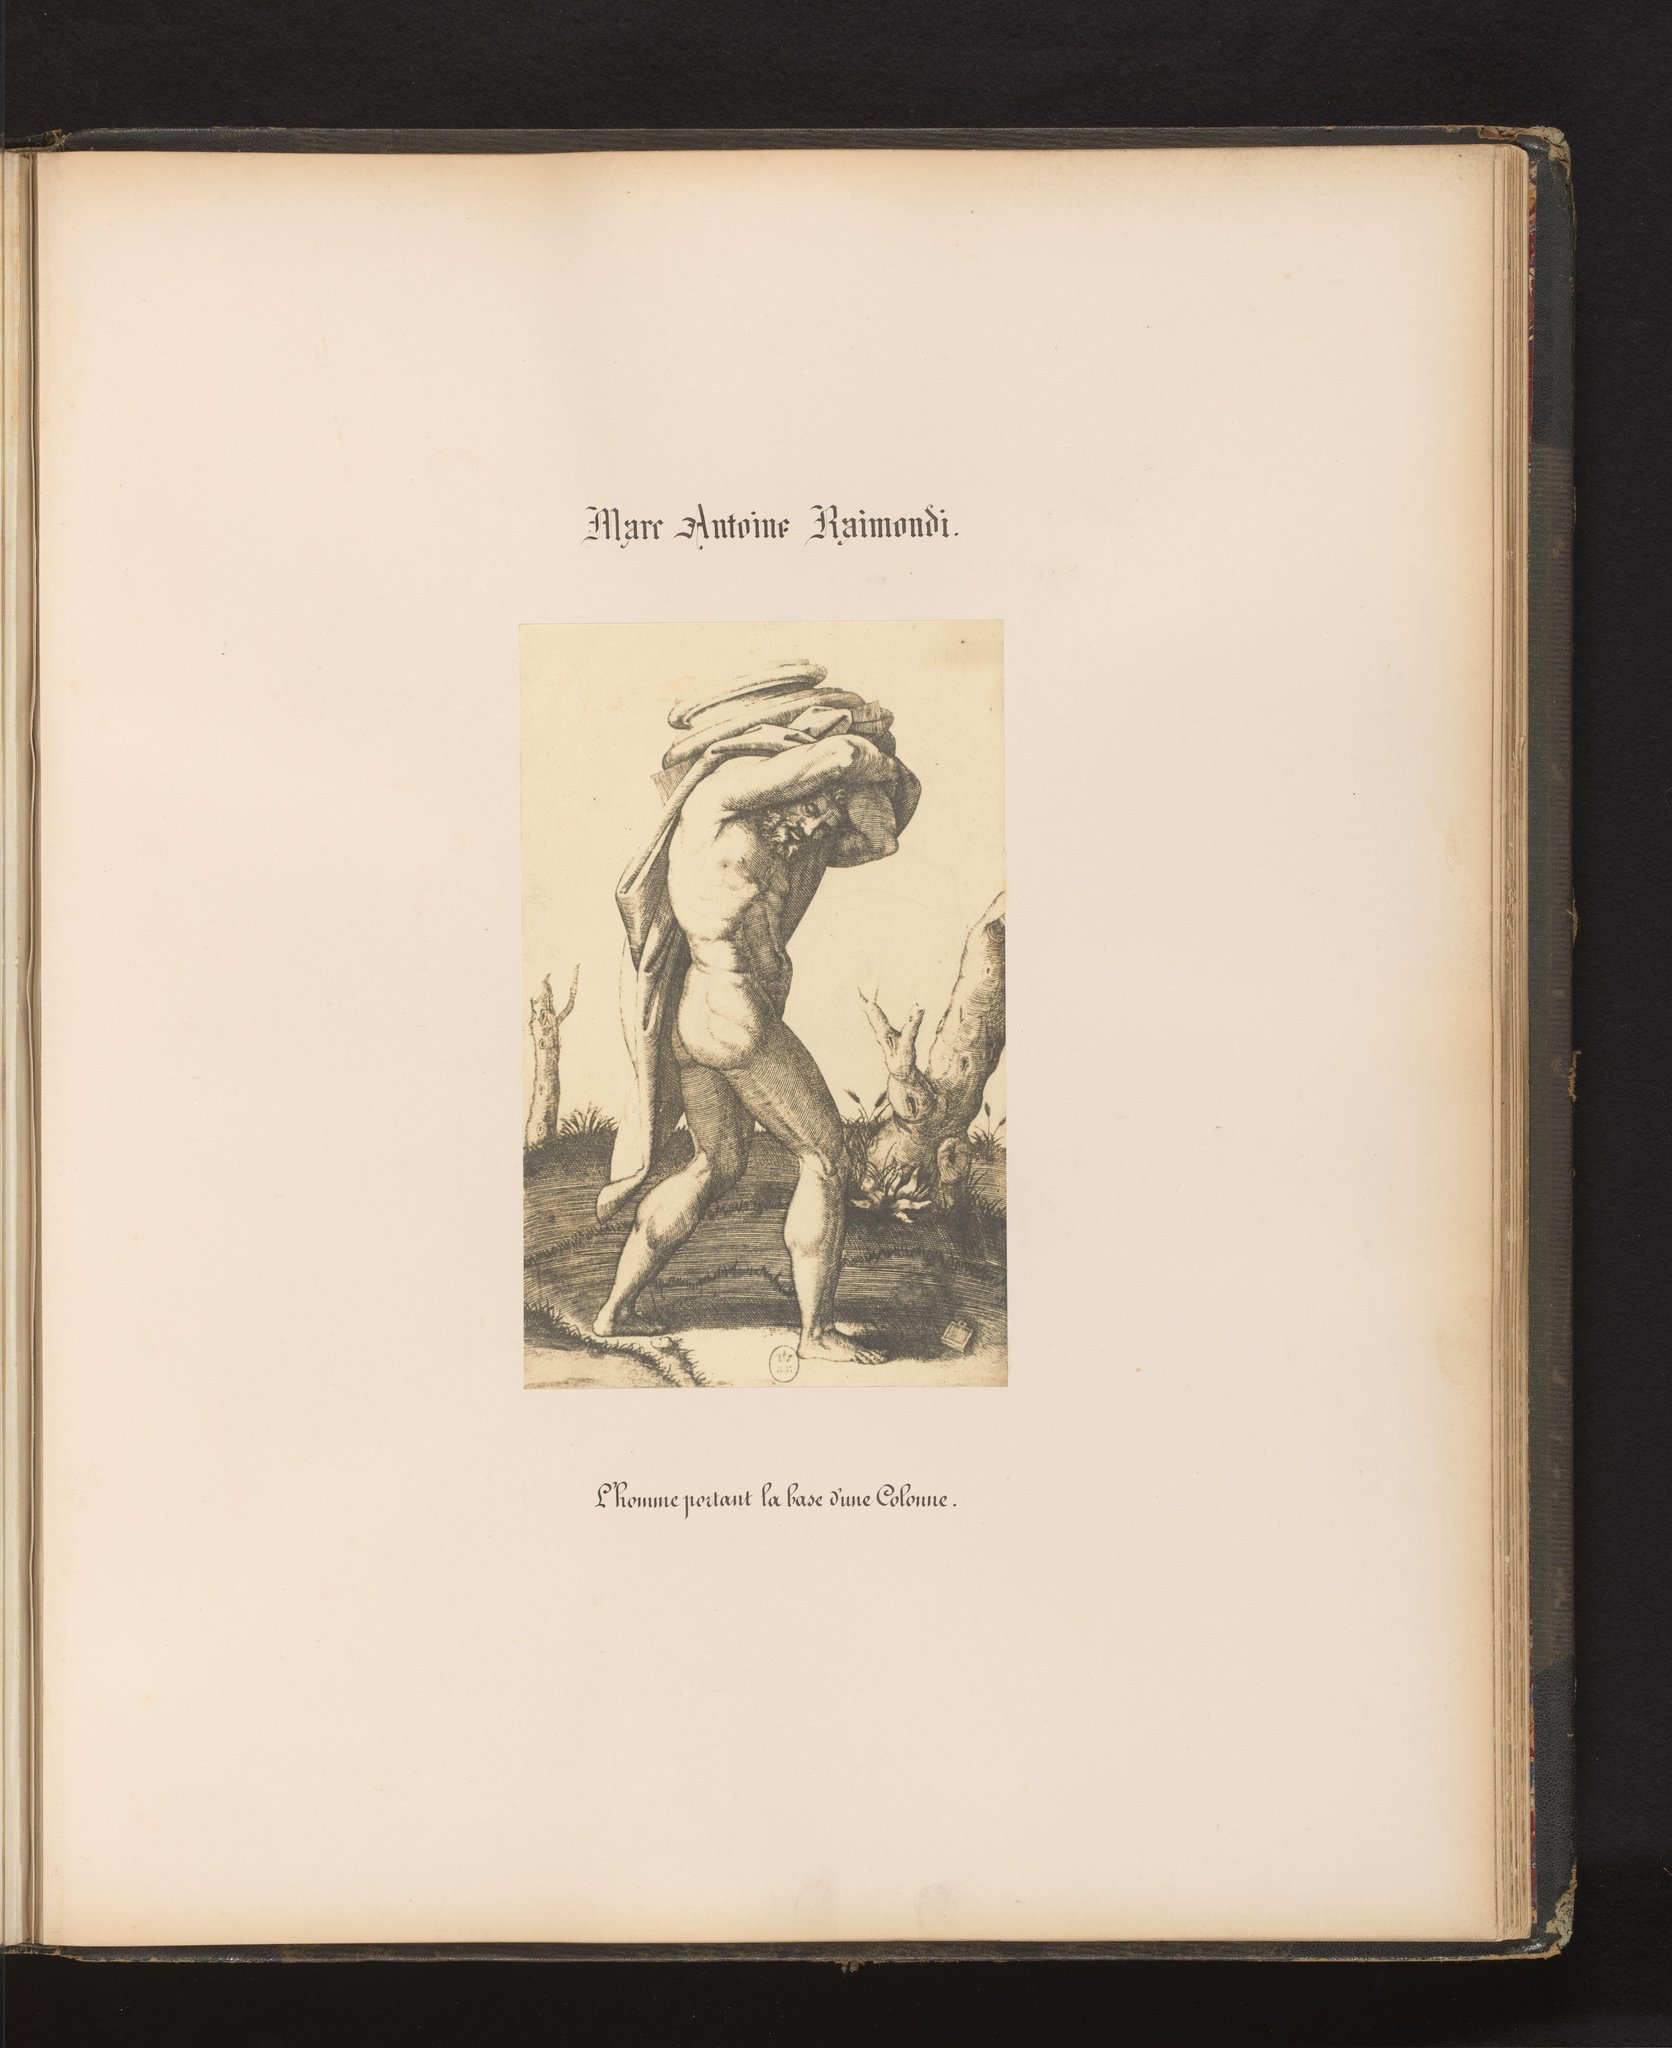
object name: photograph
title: Marc Antoine Raimondi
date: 1848-1853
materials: photographic support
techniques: salted paper print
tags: base (~ column, pillar), carrying something on the head or on the shoulders